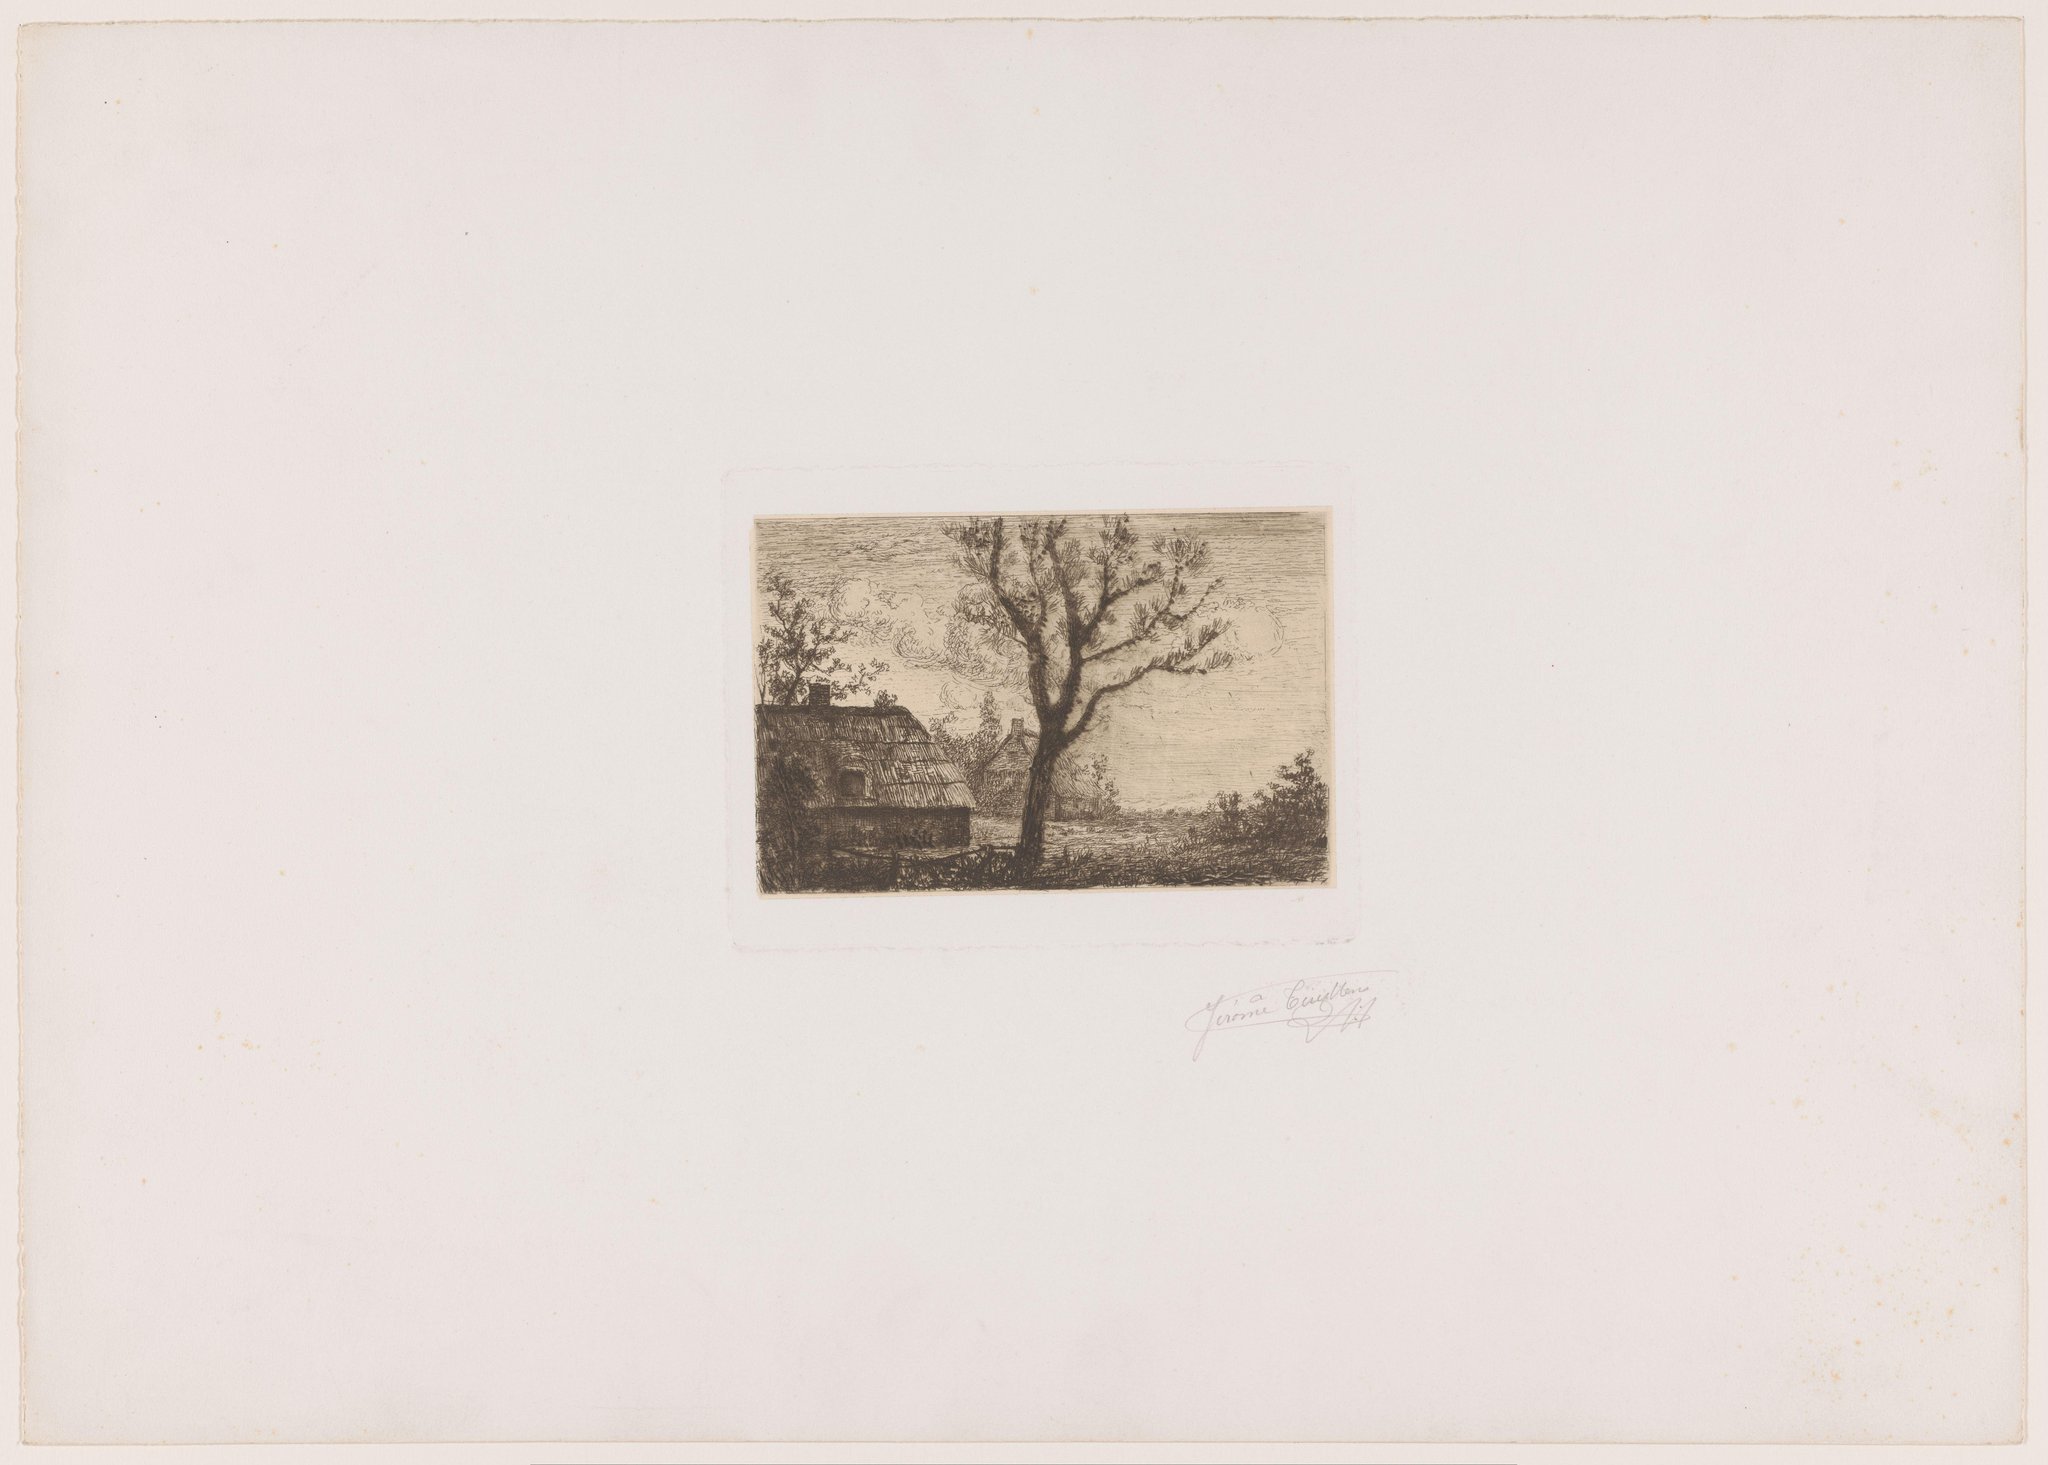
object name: print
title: Landschap met twee boerderijen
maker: jerôme tuyttens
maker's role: painter, print maker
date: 1850-1883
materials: paper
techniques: drypoint, etching, intaglio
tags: farm or solitary house in landscape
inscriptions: collector's mark: Lugt 2228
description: Sterfdatum van de prentmaker is onbekend. Daarom is voor de bepaling van de rechten van dit object gebruik gemaakt van de verwervingsdatum Rijksmuseum Amsterdam.